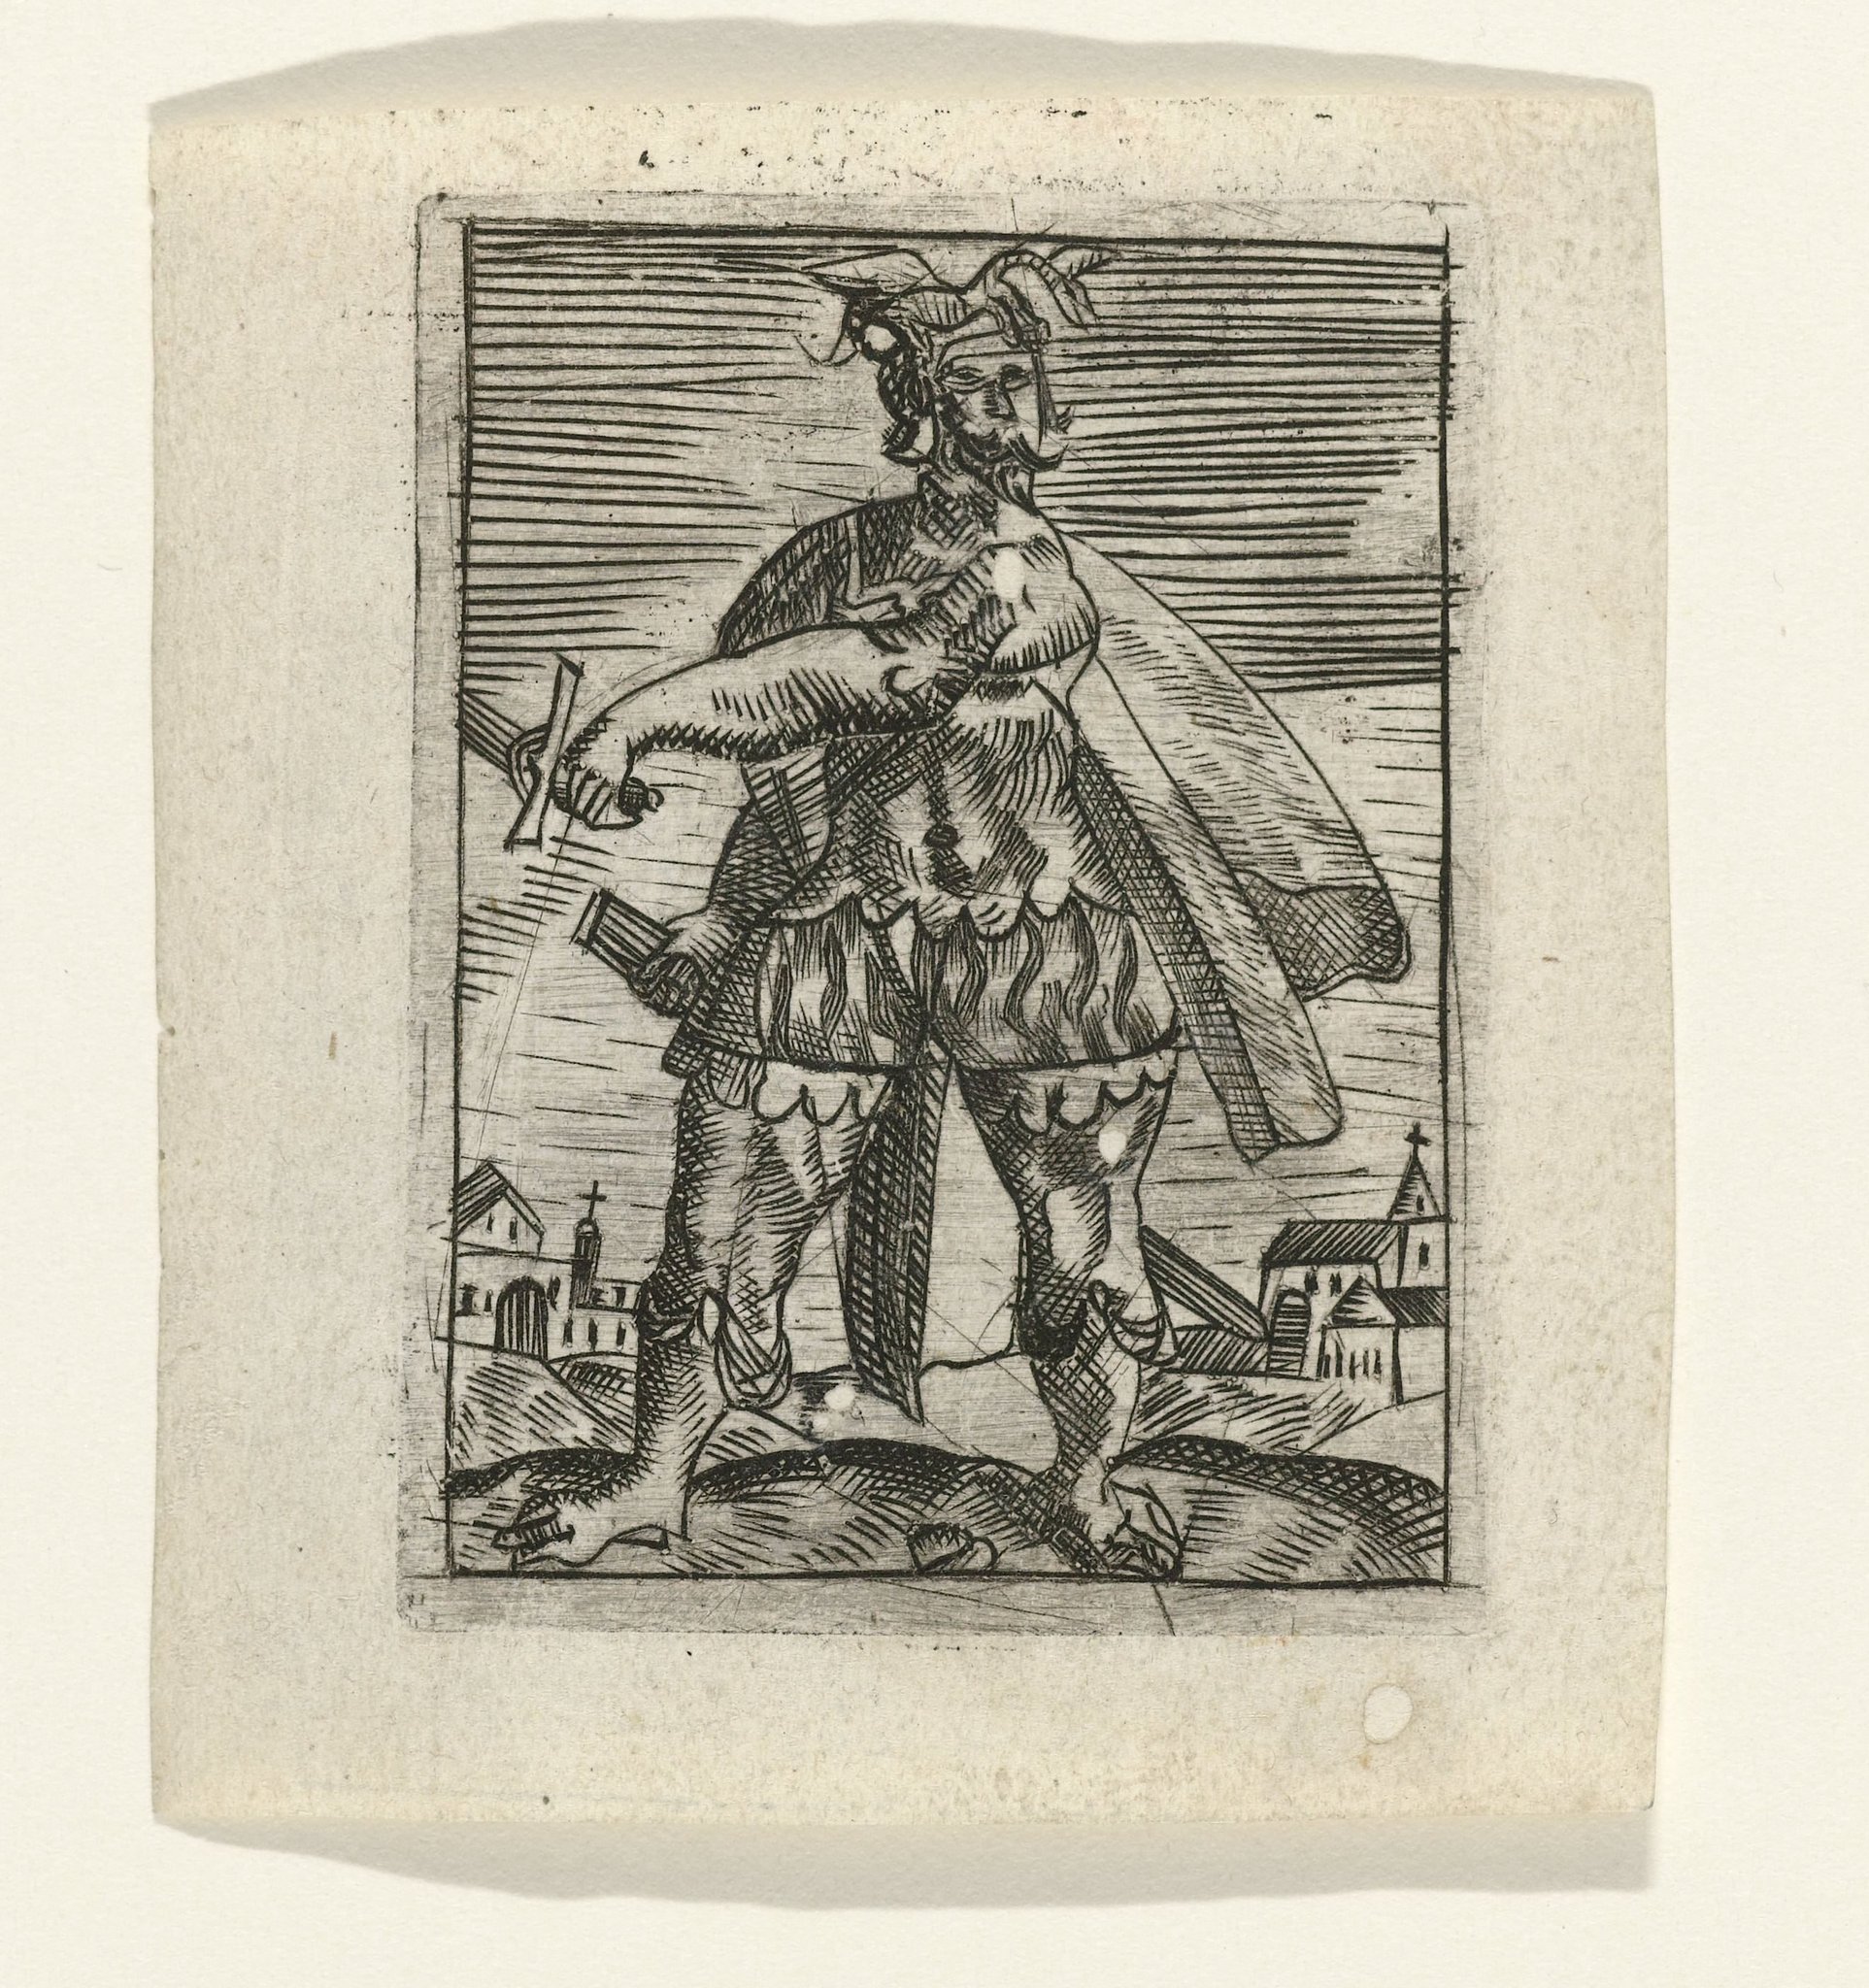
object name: print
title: Mucius Scaevola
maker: Anonymous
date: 1586-1620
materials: paper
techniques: engraving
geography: netherlands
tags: (story of) gaius mucius scaevola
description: Onbeschreven, zeer vrije en zeer primitieve, spiegelbeeldige kopie naar de gravure van Hendrick Goltzius.